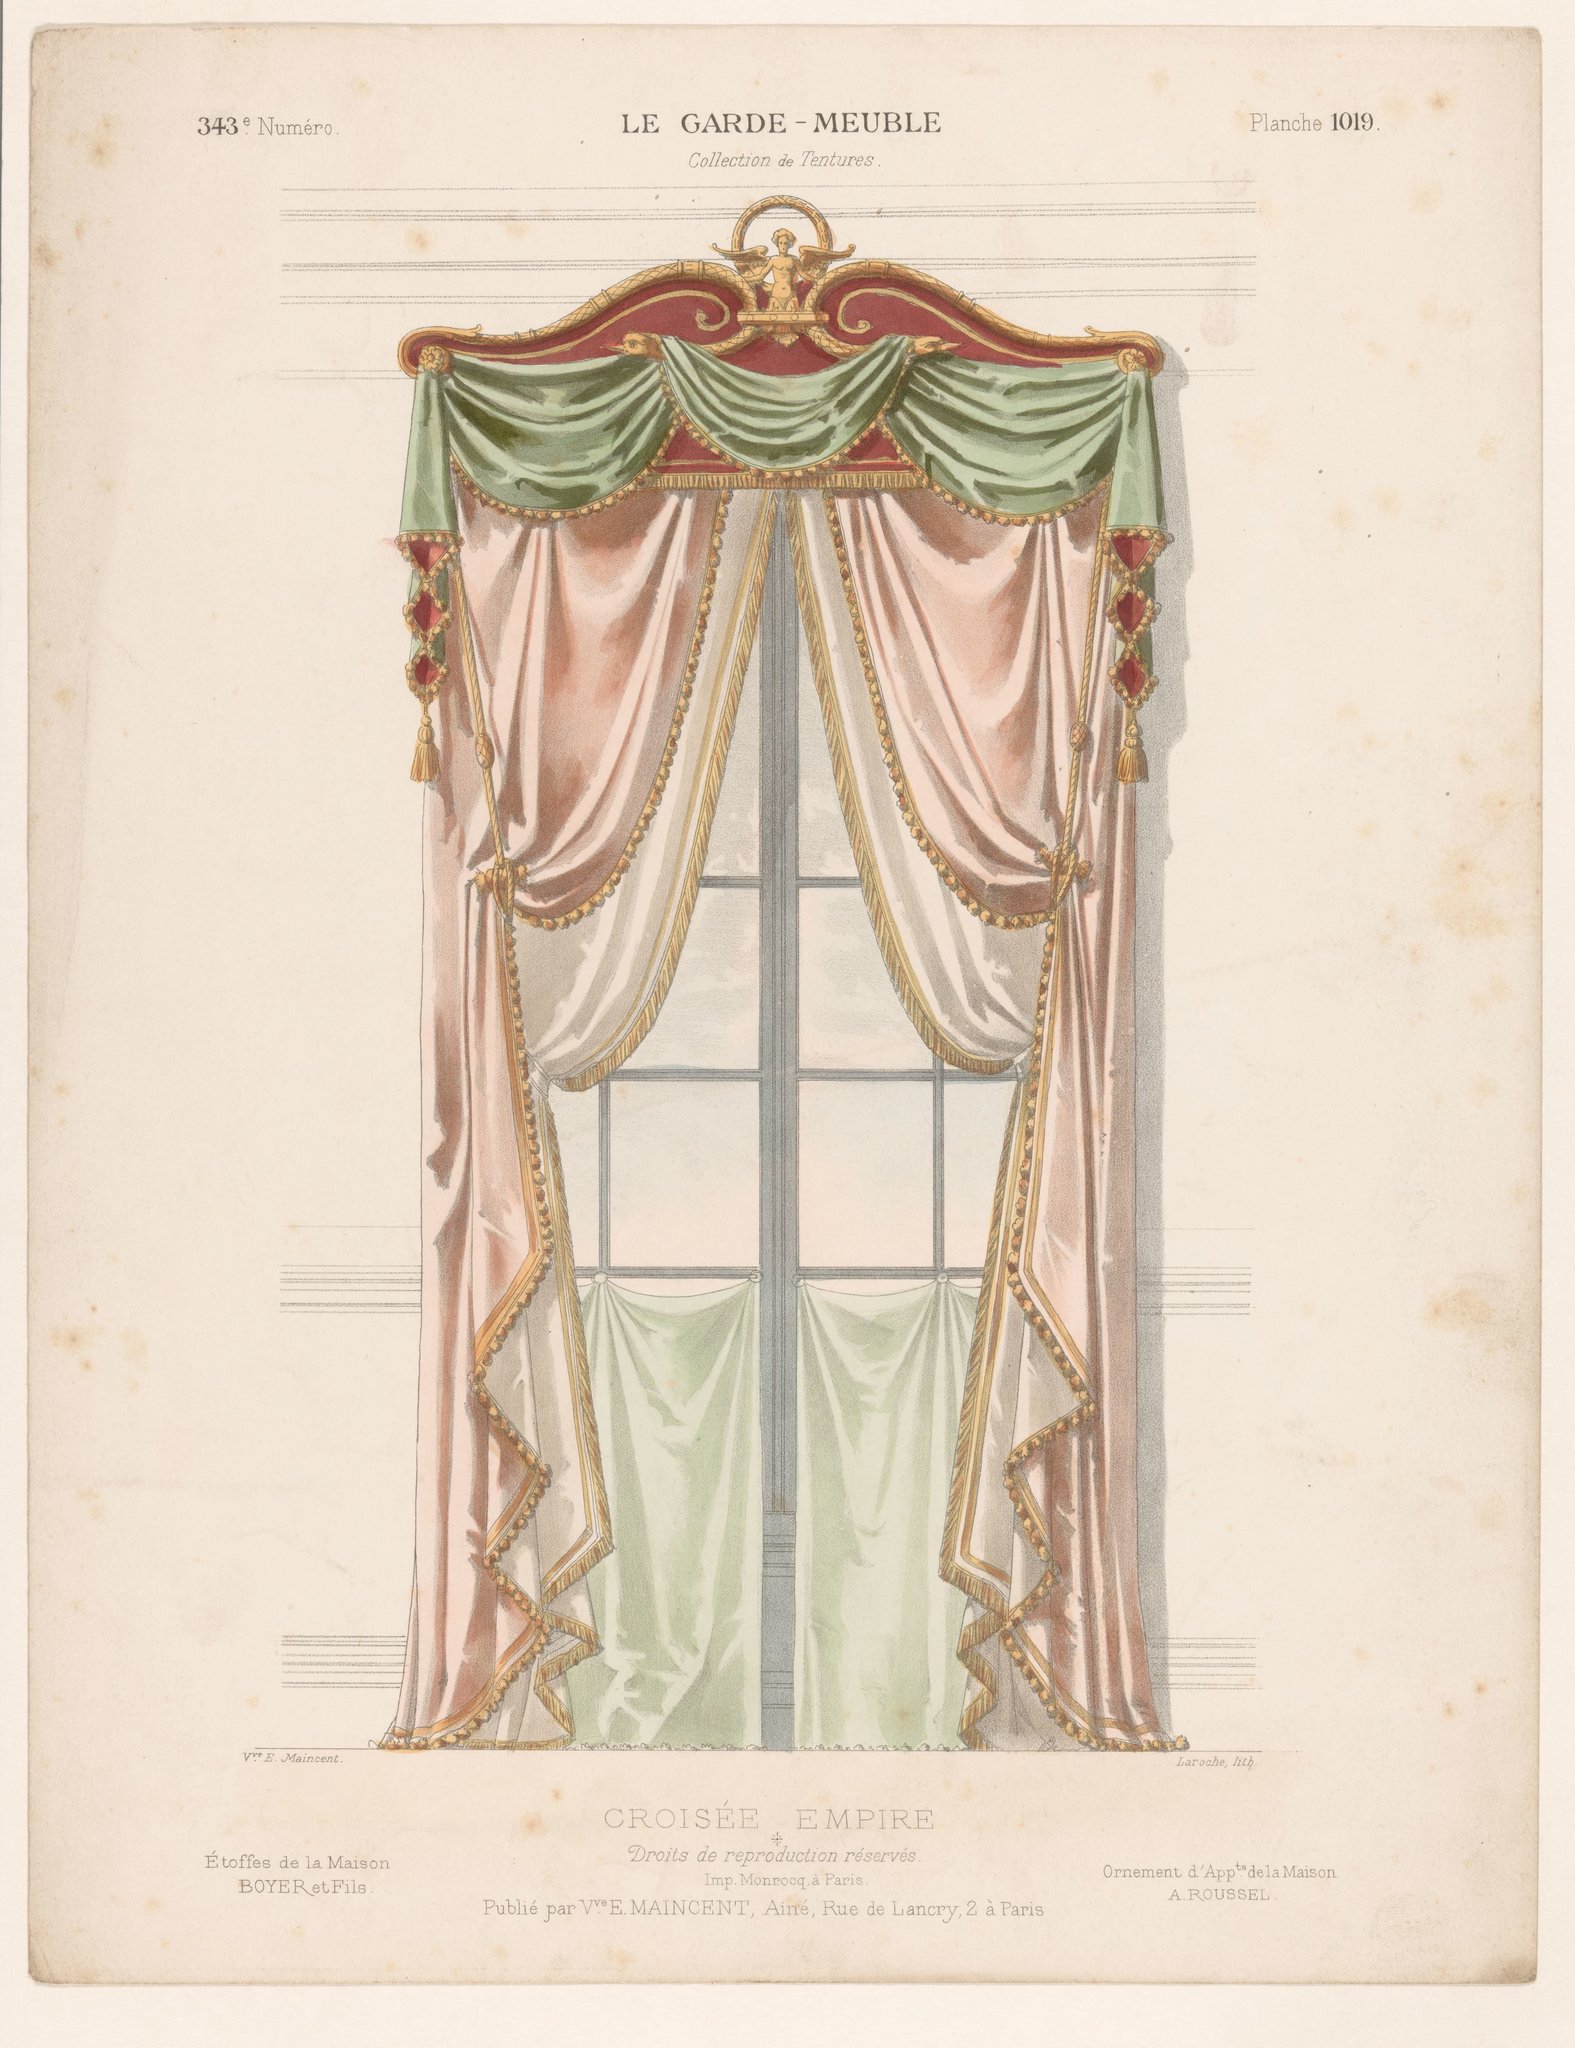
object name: print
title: Le Garde-Meuble / Collection de Tentures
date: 1895-1910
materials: paper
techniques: hand coloring, lithograph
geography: paris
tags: window, hangings and drapery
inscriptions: : ‘Droits de reproduction réservés.’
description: Kruisvenster met gedrapeerde gordijnen in empirestijl. Prent uit 343e Livraison.